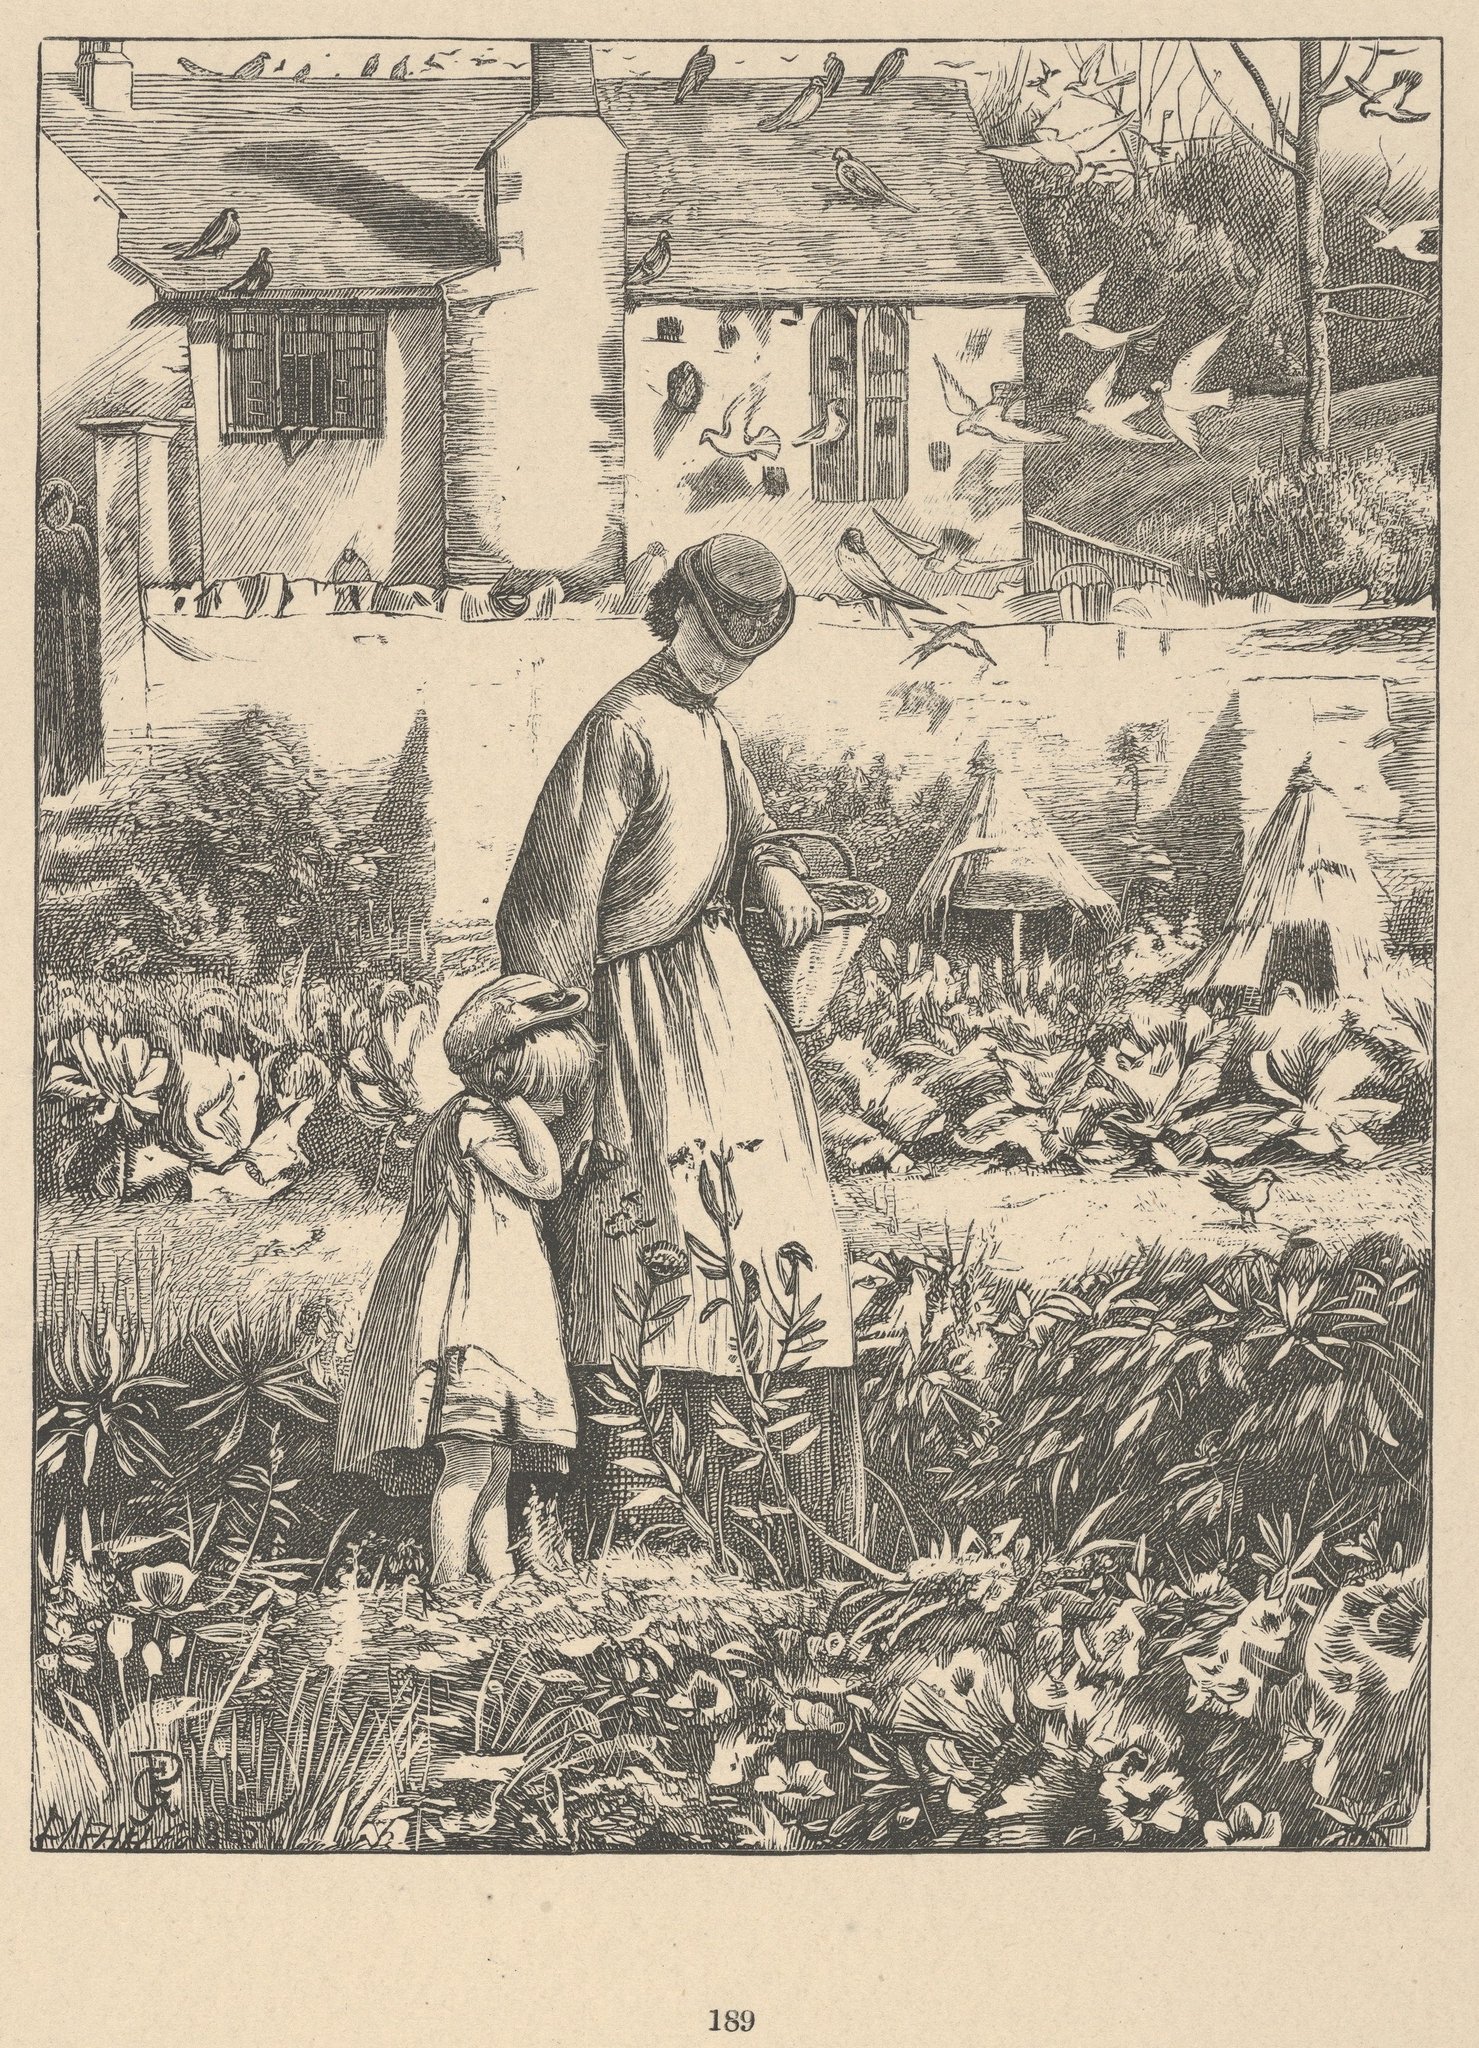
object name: print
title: The Island Bee, from "Picture Poesies"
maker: george john pinwell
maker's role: artist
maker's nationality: british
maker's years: 1842-1875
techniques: engraving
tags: birds,houses,gardens,girls,women